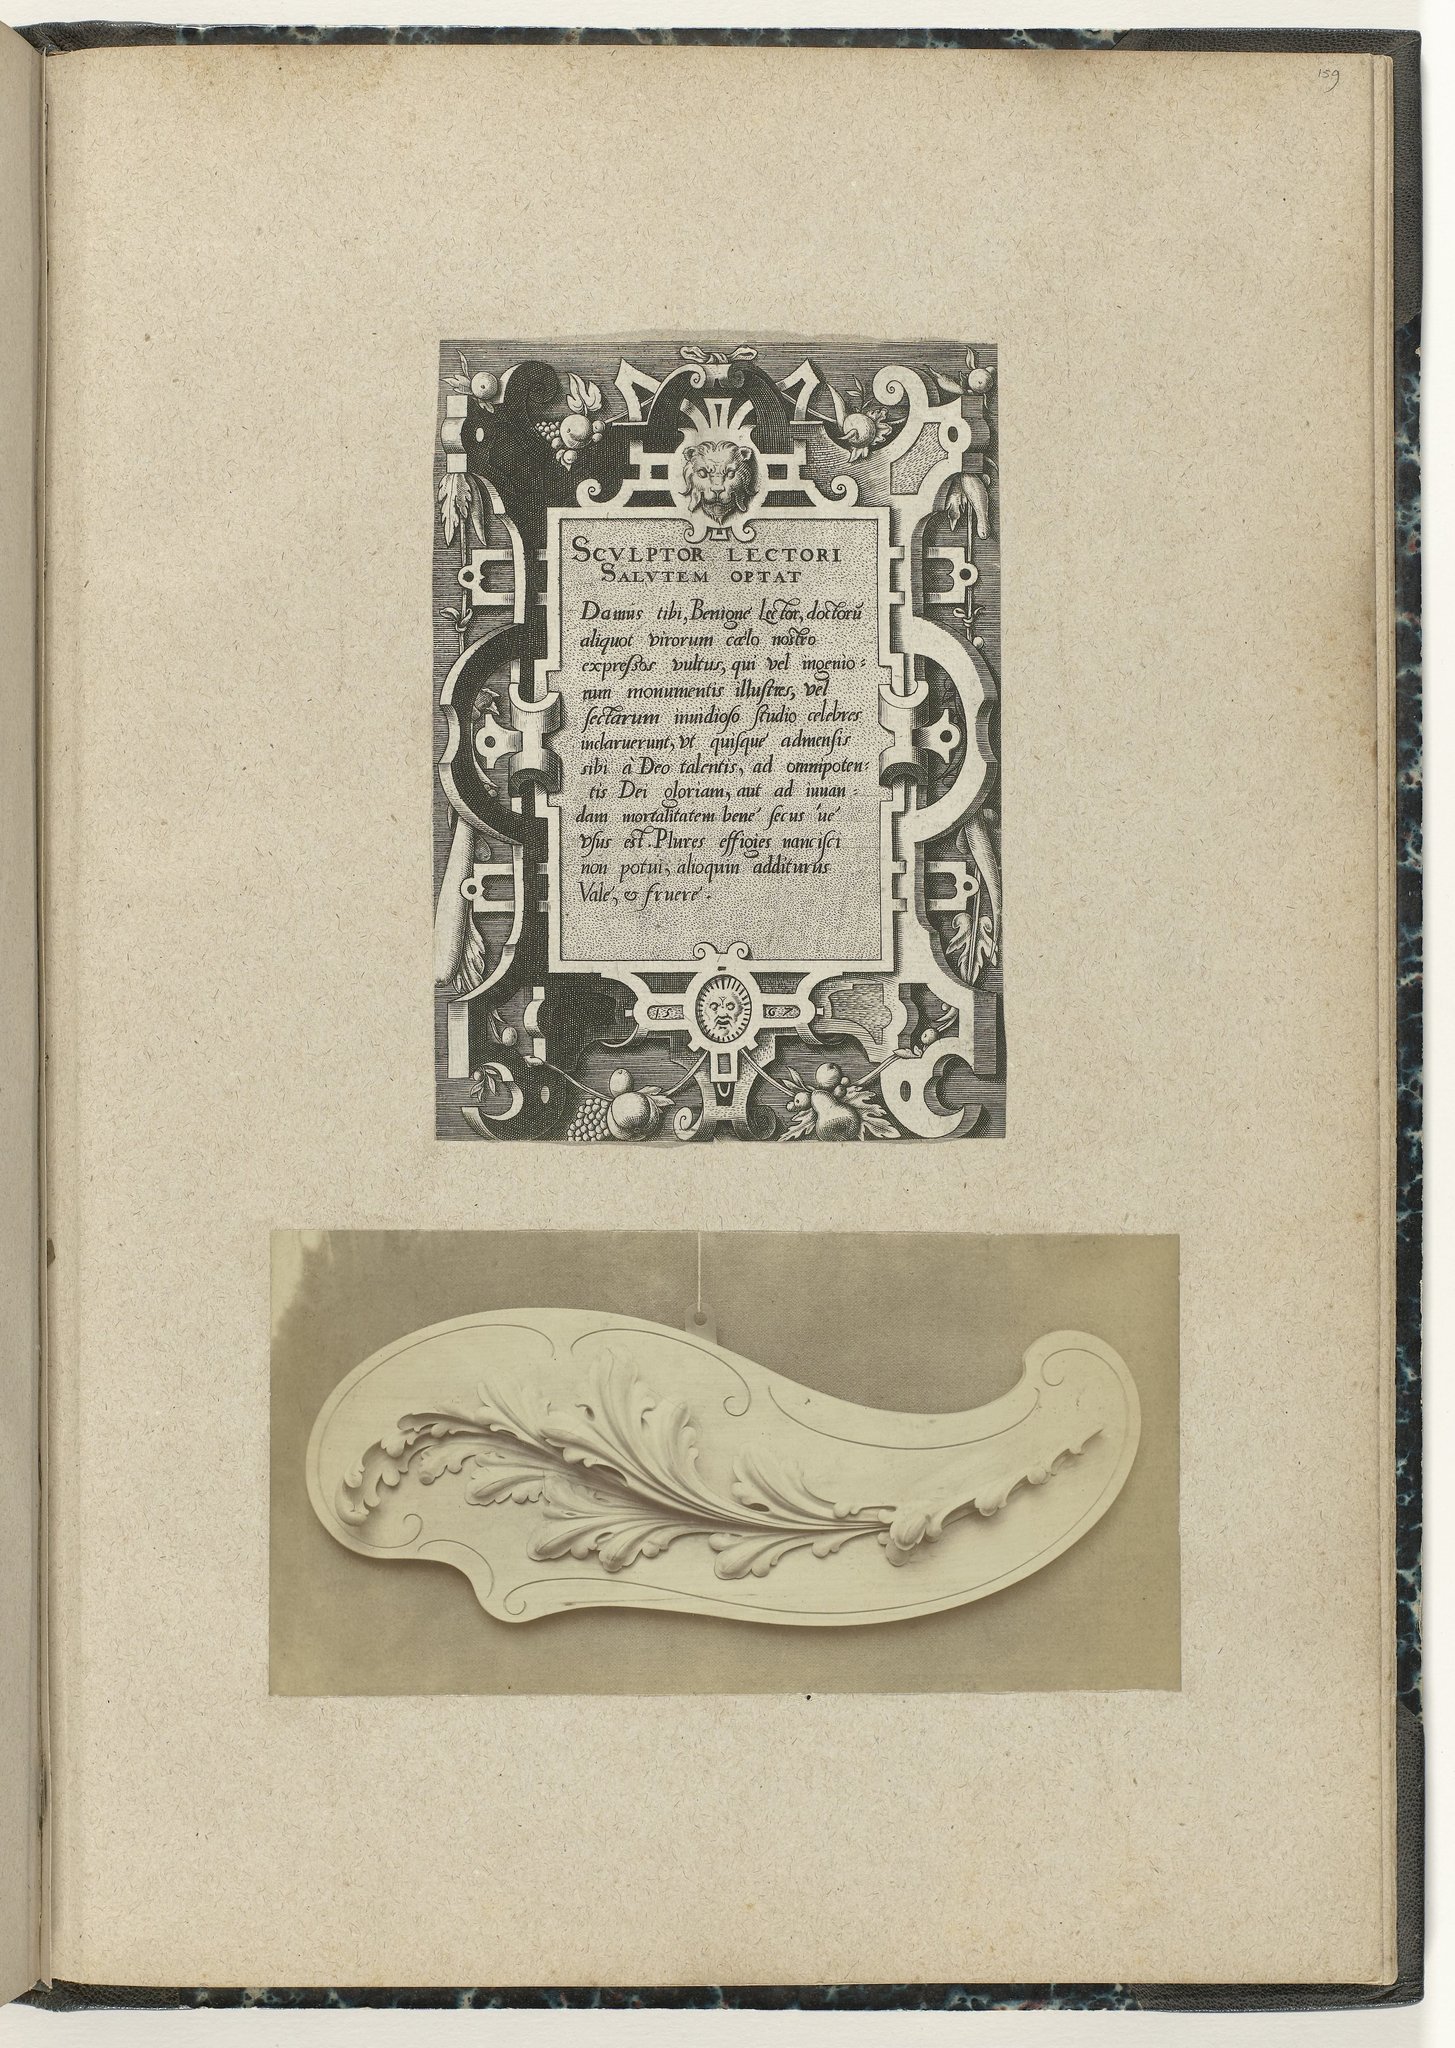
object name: print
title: Cartouche en bladrank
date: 1567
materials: paper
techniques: albumen print, engraving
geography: haarlem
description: De prent maakte deel uit van de eerste uitgave van Galles serie portretten van geleerden 'Virorum doctorum de disciplinis benemerentium effigies' uit 1567 (titel afgeleid van de tweede uitgave uit 1572). Galle gebruikte de plaat opnieuw in 1572 voor zijn serie van pauselijke portretten 'Pontificum Maximorum XXVII effigies' (NHD 692).